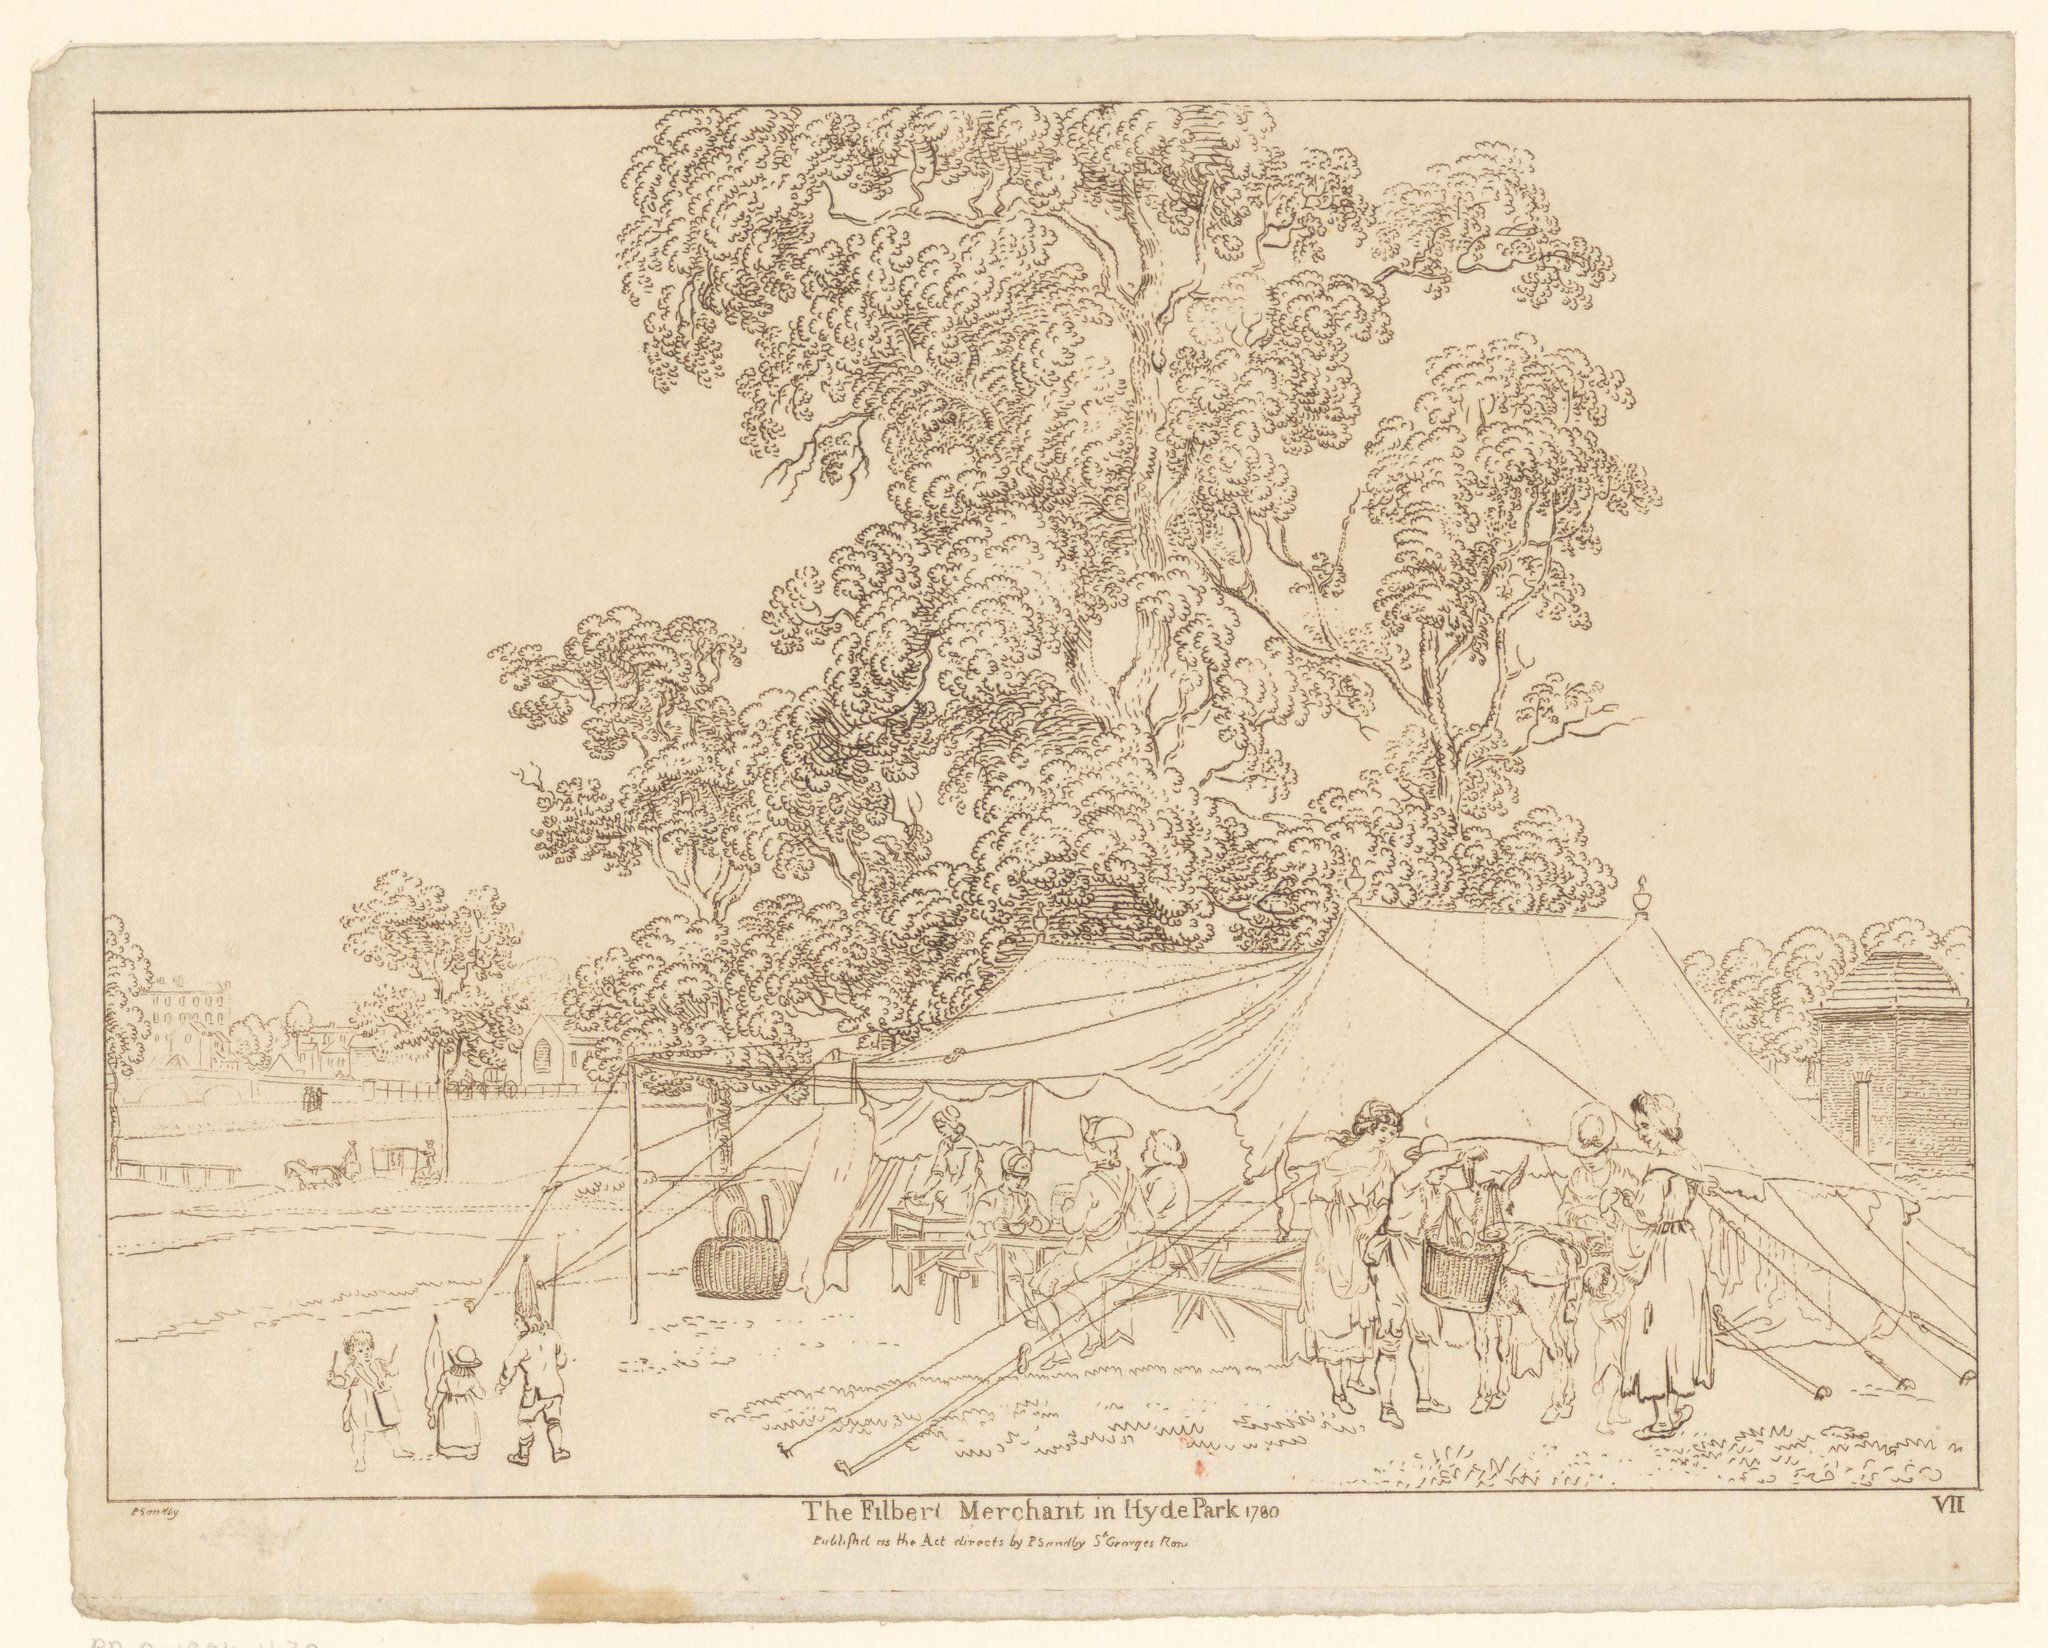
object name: print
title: Gezichten op militaire kampementen, eerste set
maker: paul sandby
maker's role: draughtsman, print maker, publisher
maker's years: 1725-1809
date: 1780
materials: paper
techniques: etching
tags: (military) camp with tents, public gardens, park (+ city(-scape) with figures, staffage)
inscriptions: collector's mark: Lugt 2228